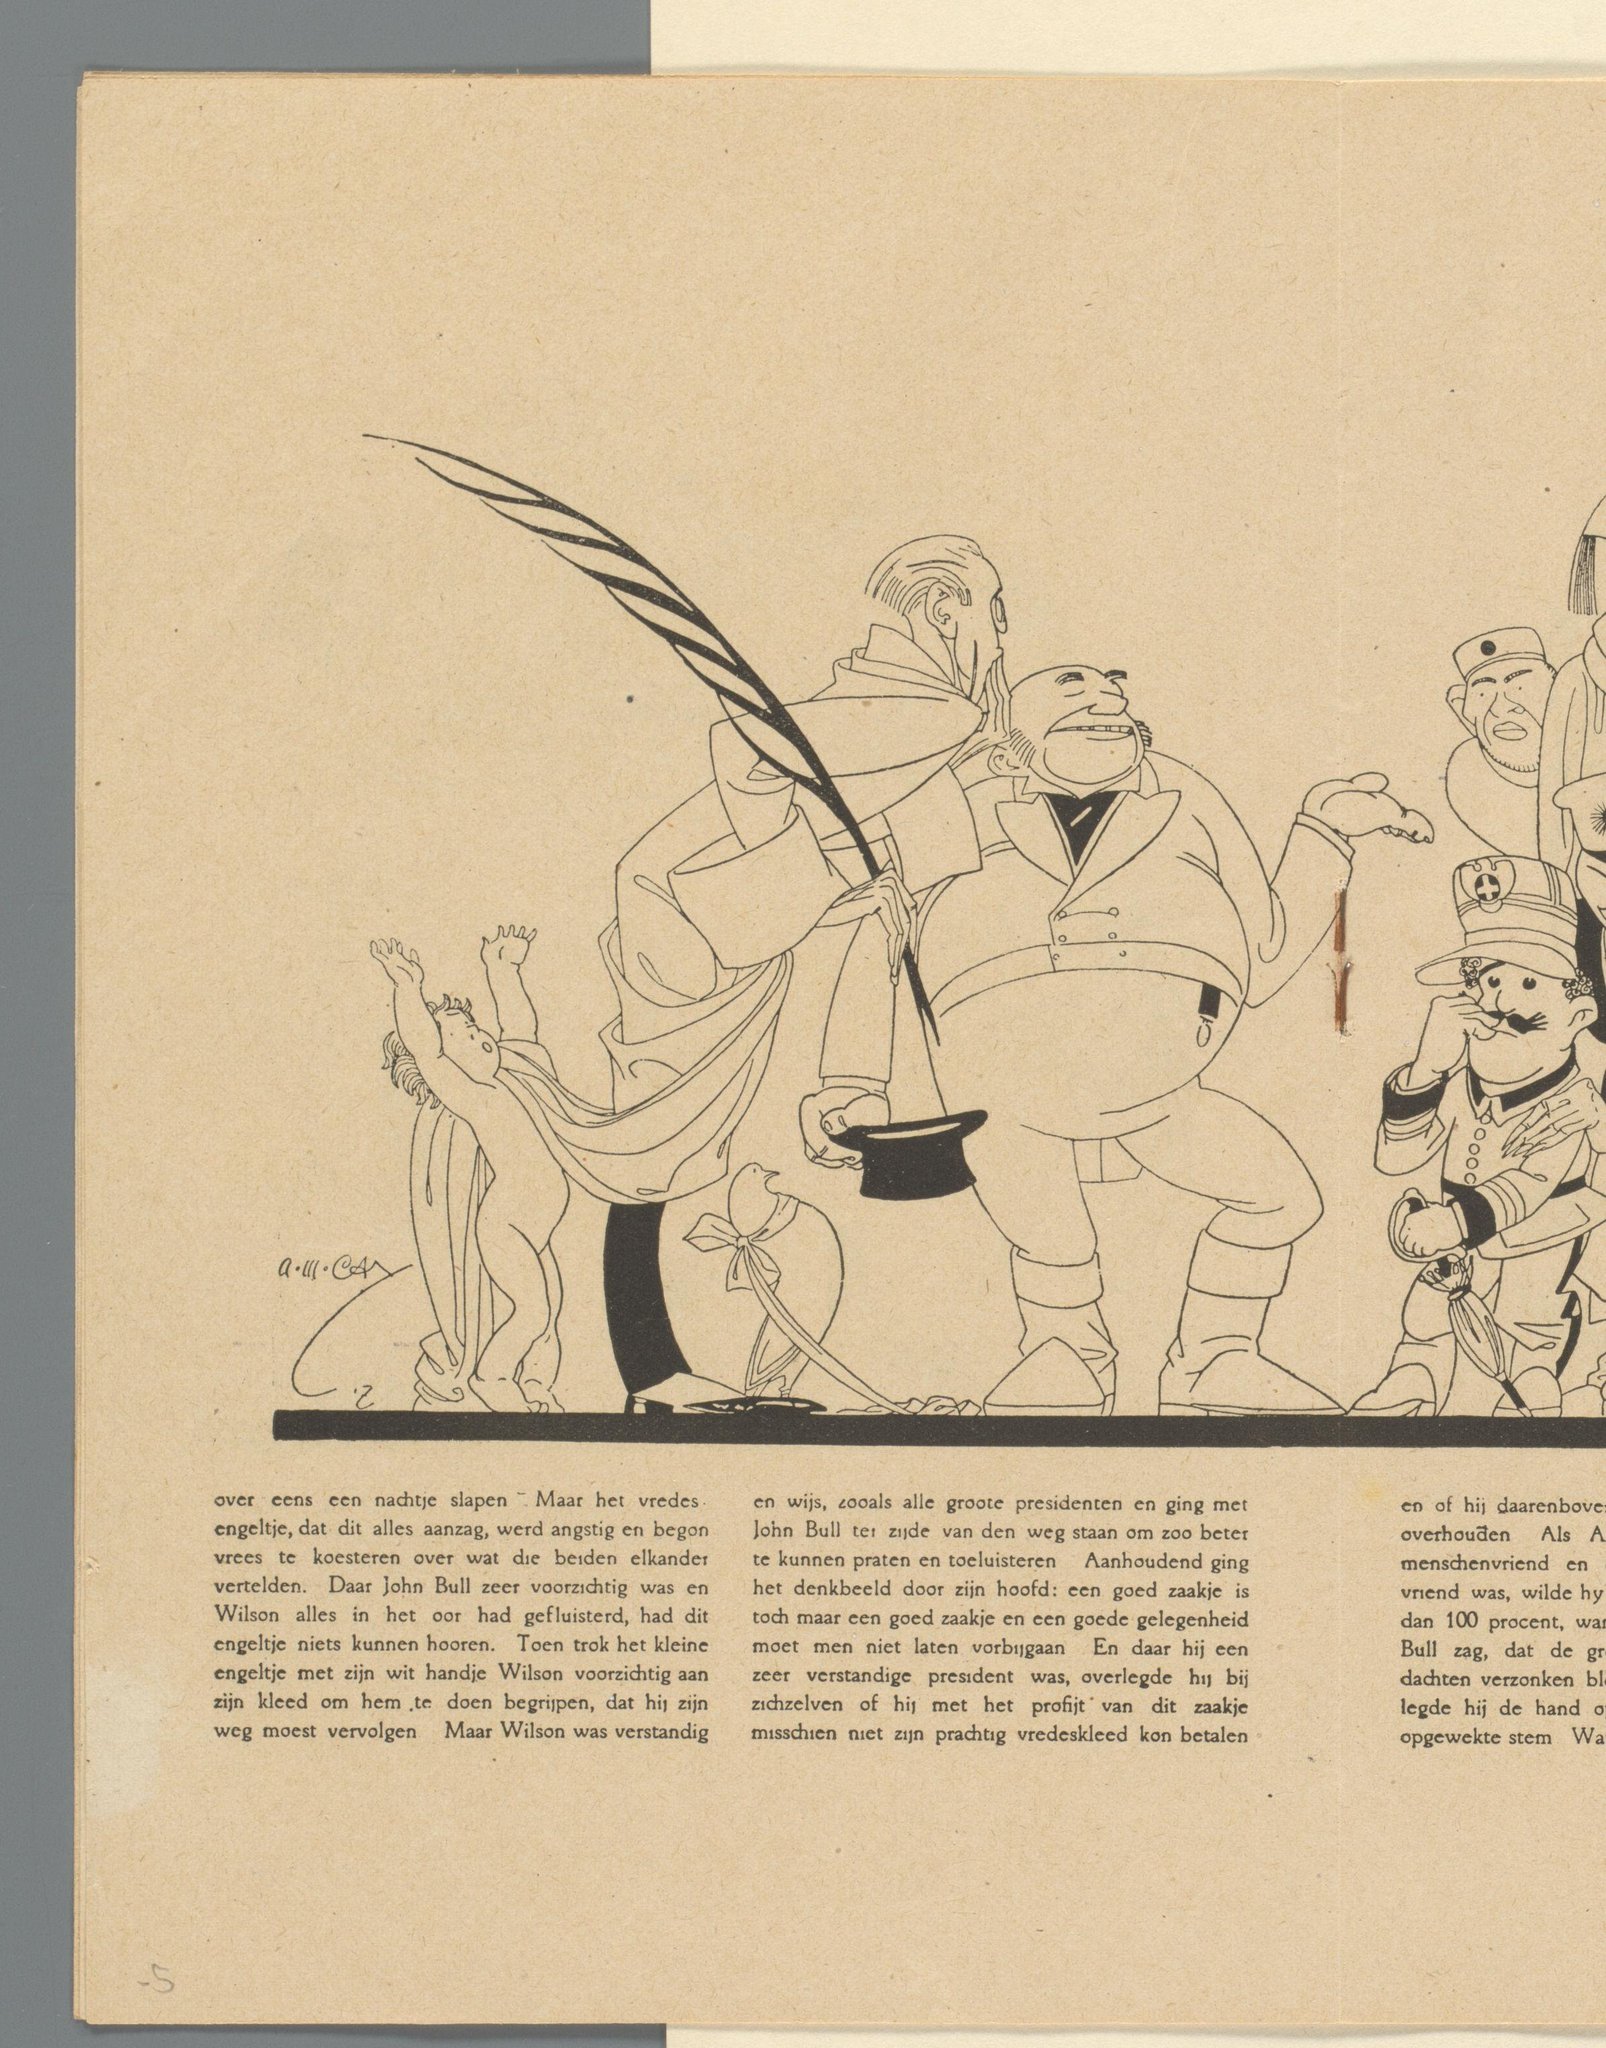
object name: photomechanical print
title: John Bull toont Woodrow Wilson zijn vele vrienden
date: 1917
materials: paper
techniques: printing block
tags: personifications of countries, nations, states, districts, etc., president ~ head of republic, political caricatures and satires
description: Links Bull en Wilson, en rechts een aantal landen voorgesteld door personen. Deze prent maakt deel uit van een boek.